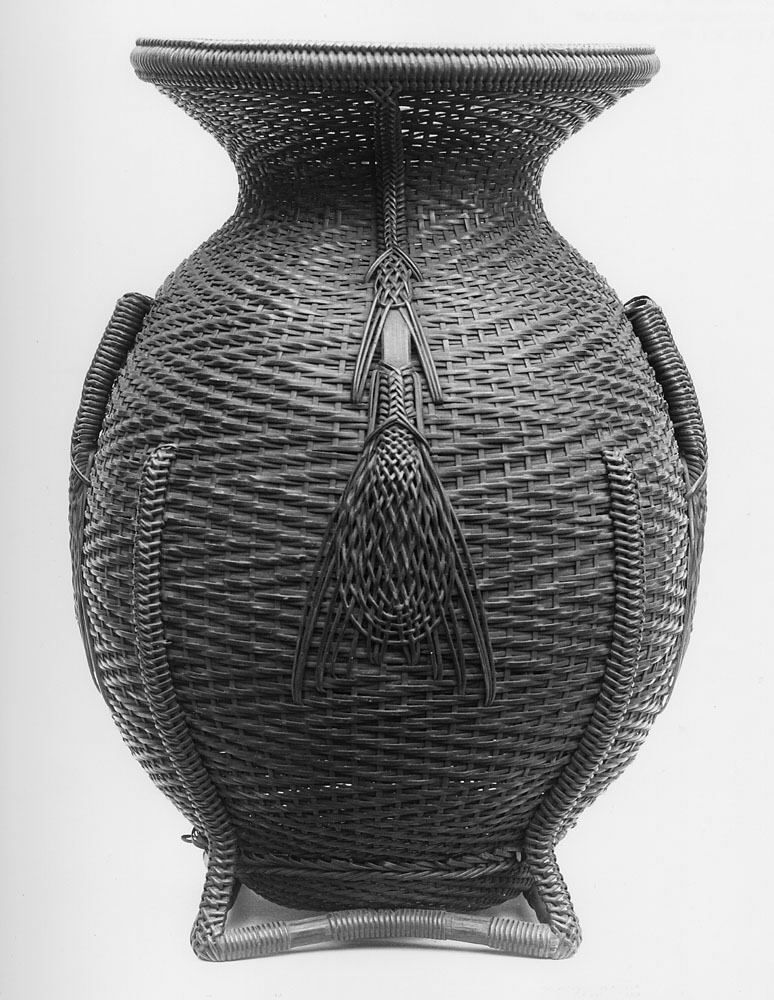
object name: basket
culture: japanese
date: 1801-1900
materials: rattan